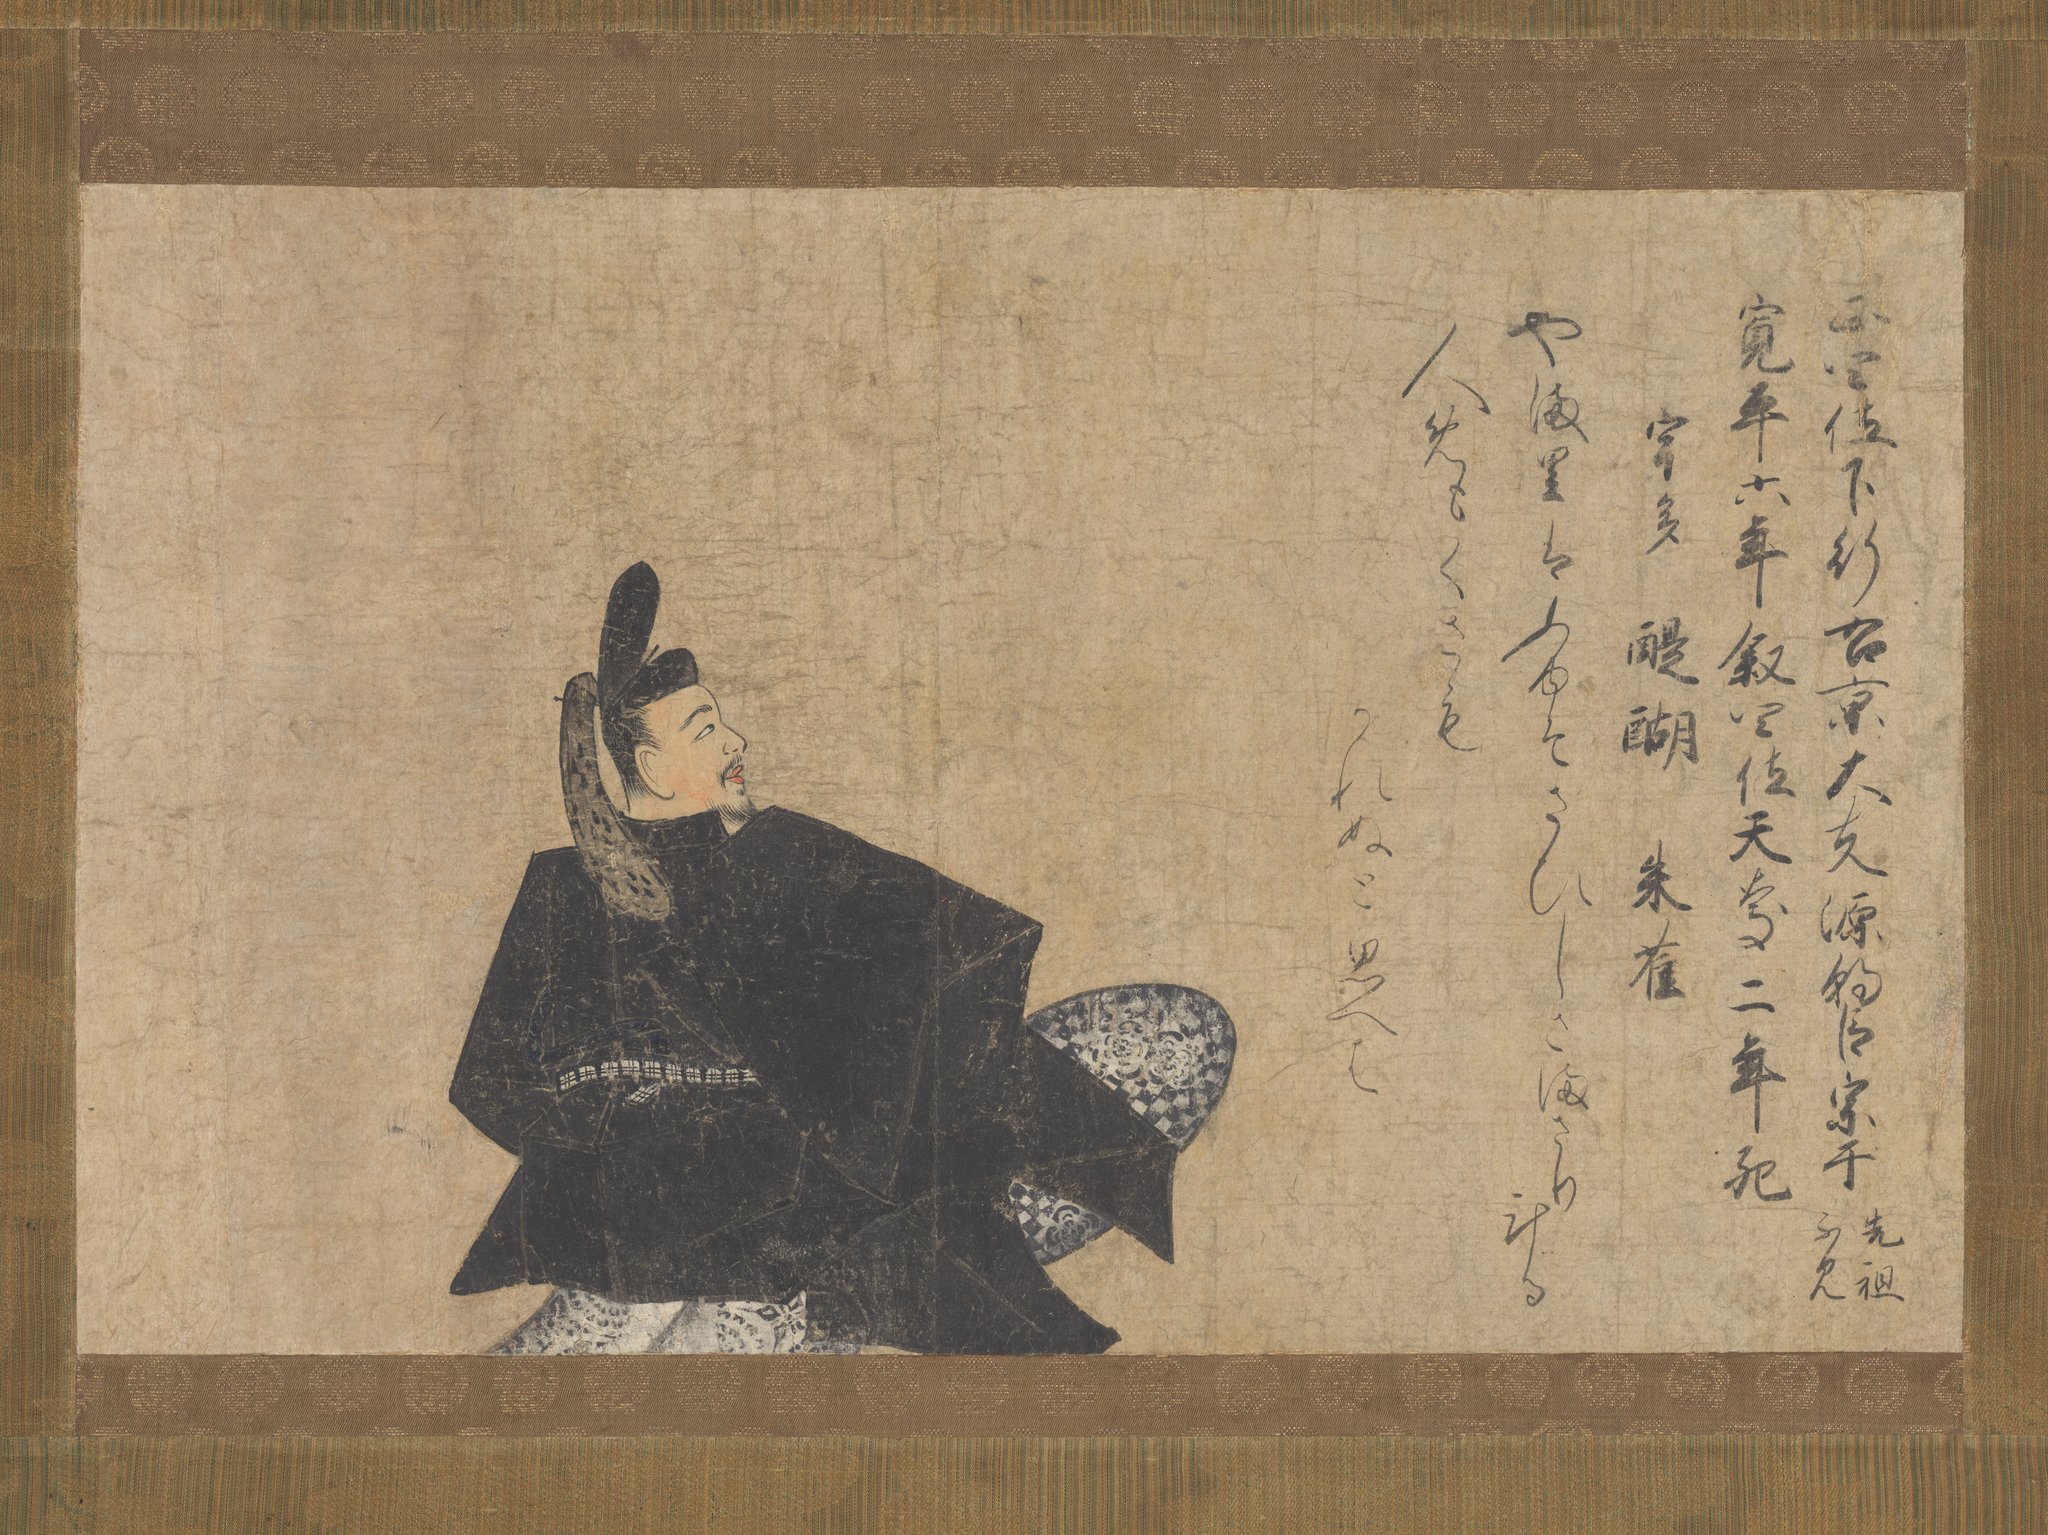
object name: hanging scroll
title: Portrait of Minamoto no Muneyuki, from the “Fujifusa Version of the Handscroll of Thirty-Six Poetic Immortals”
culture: japanese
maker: emperor godaigo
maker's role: artist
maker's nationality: japanese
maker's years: 1288-1339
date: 1401-1433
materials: ink, paper